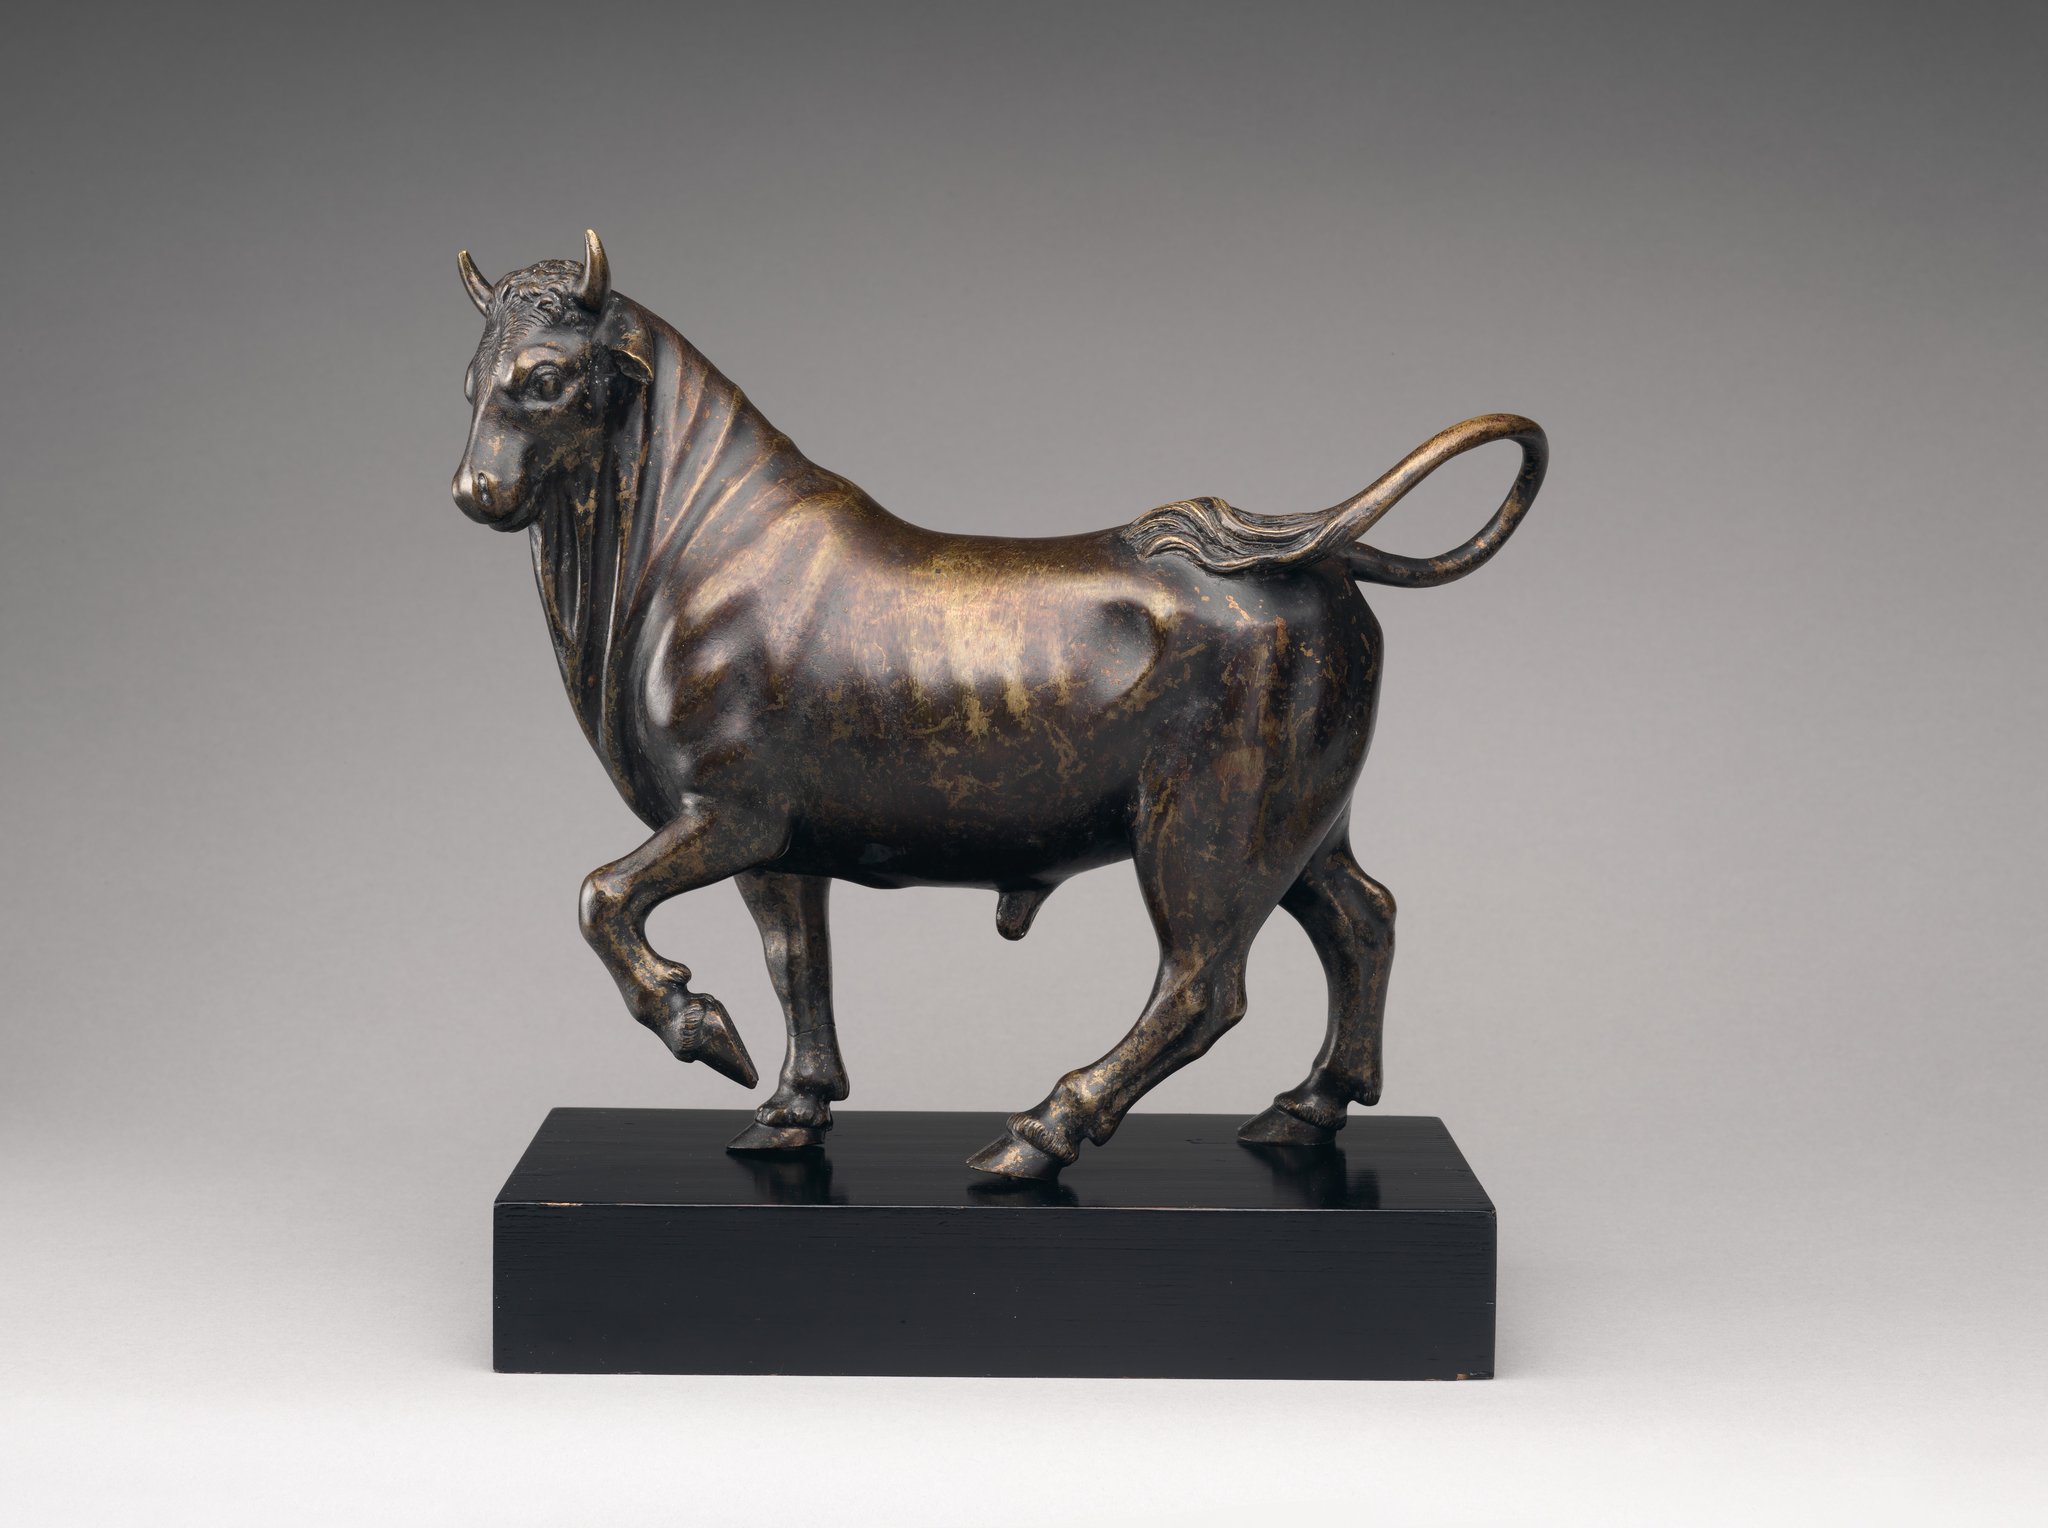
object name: statuette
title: Bull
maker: giambologna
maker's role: artist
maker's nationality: netherlandish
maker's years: 1529-1608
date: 1701-1900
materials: bronze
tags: bulls